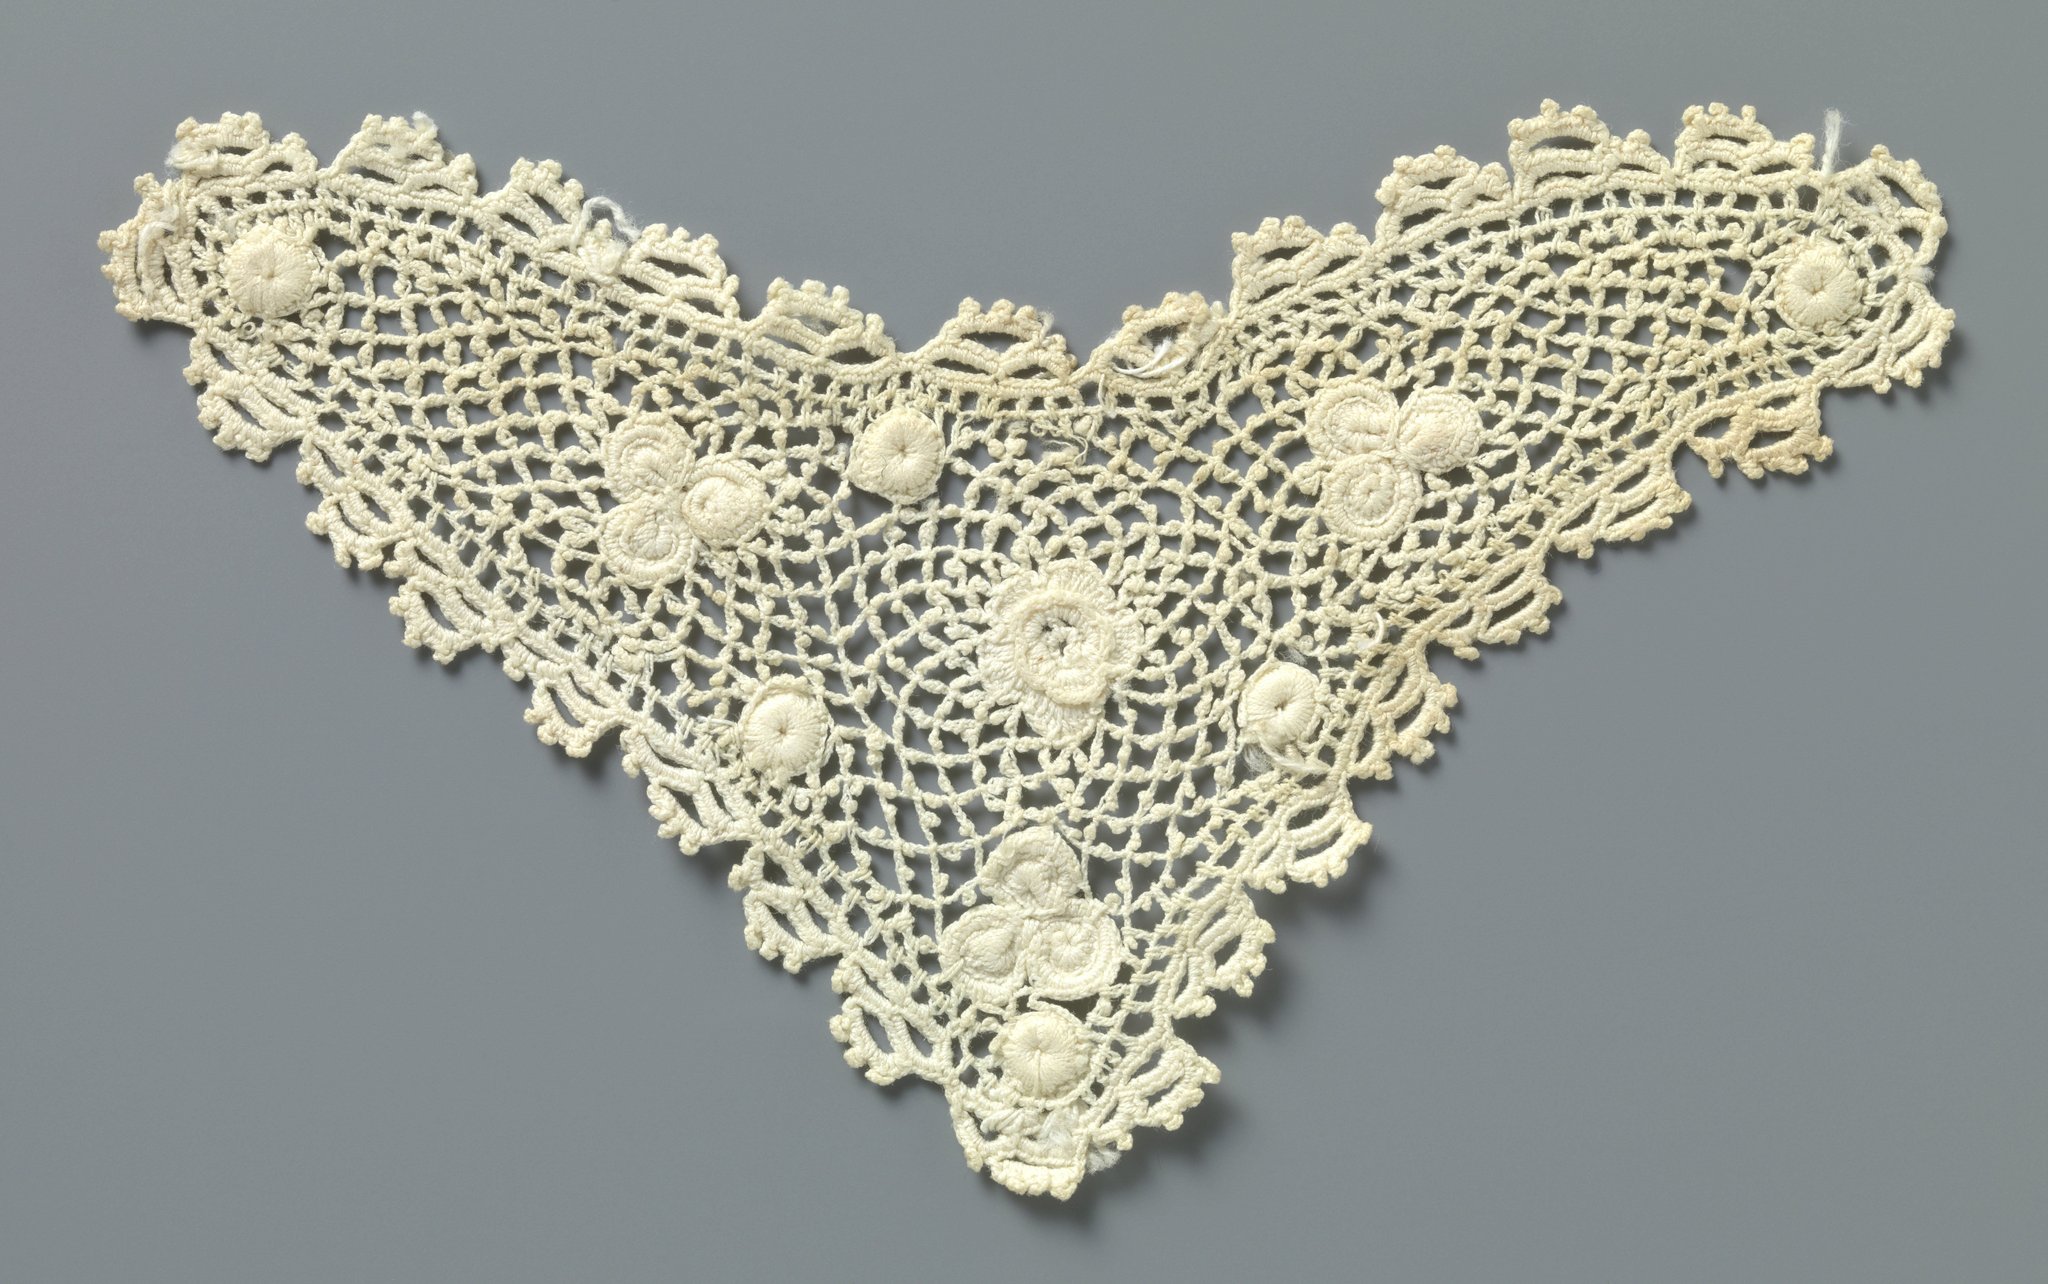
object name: oplegstuk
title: Oplegstuk van gehaakte kant met roosje en klaverblaadjes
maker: Anonymous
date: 1890-1909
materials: cotton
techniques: crocheted lace, irish crochet lace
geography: ireland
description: Het is een aanname dat deze Ierse gehaakte kant ook daadwerkelijk in Ierland is gemaakt. Ierse gehaakte kant kent zijn oorsprong rond 1760 en kwam vanaf 1840 in ontwikkeling. Aangezien volgens Martine Bruggeman (Kant in Europa) de Ierse haakindustrie aan het eind van de 19e eeuw gereorganiseerd werd en in populariteit groeide, is het hier beschreven stuk gedateerd rond 1890, tot 1909 vanwege de datering in het eerste decennium van populariteit van Ierse gehaakte kant volgens het Kantlexicon (Johan Coene).